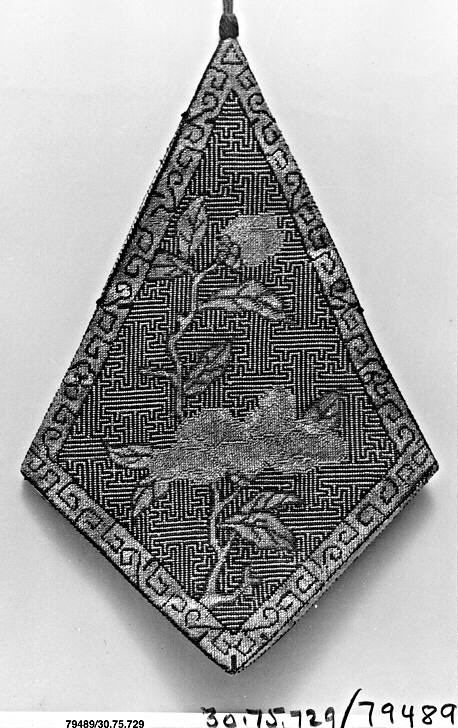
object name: bag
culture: chinese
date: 1701-1900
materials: metal thread, silk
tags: flowers